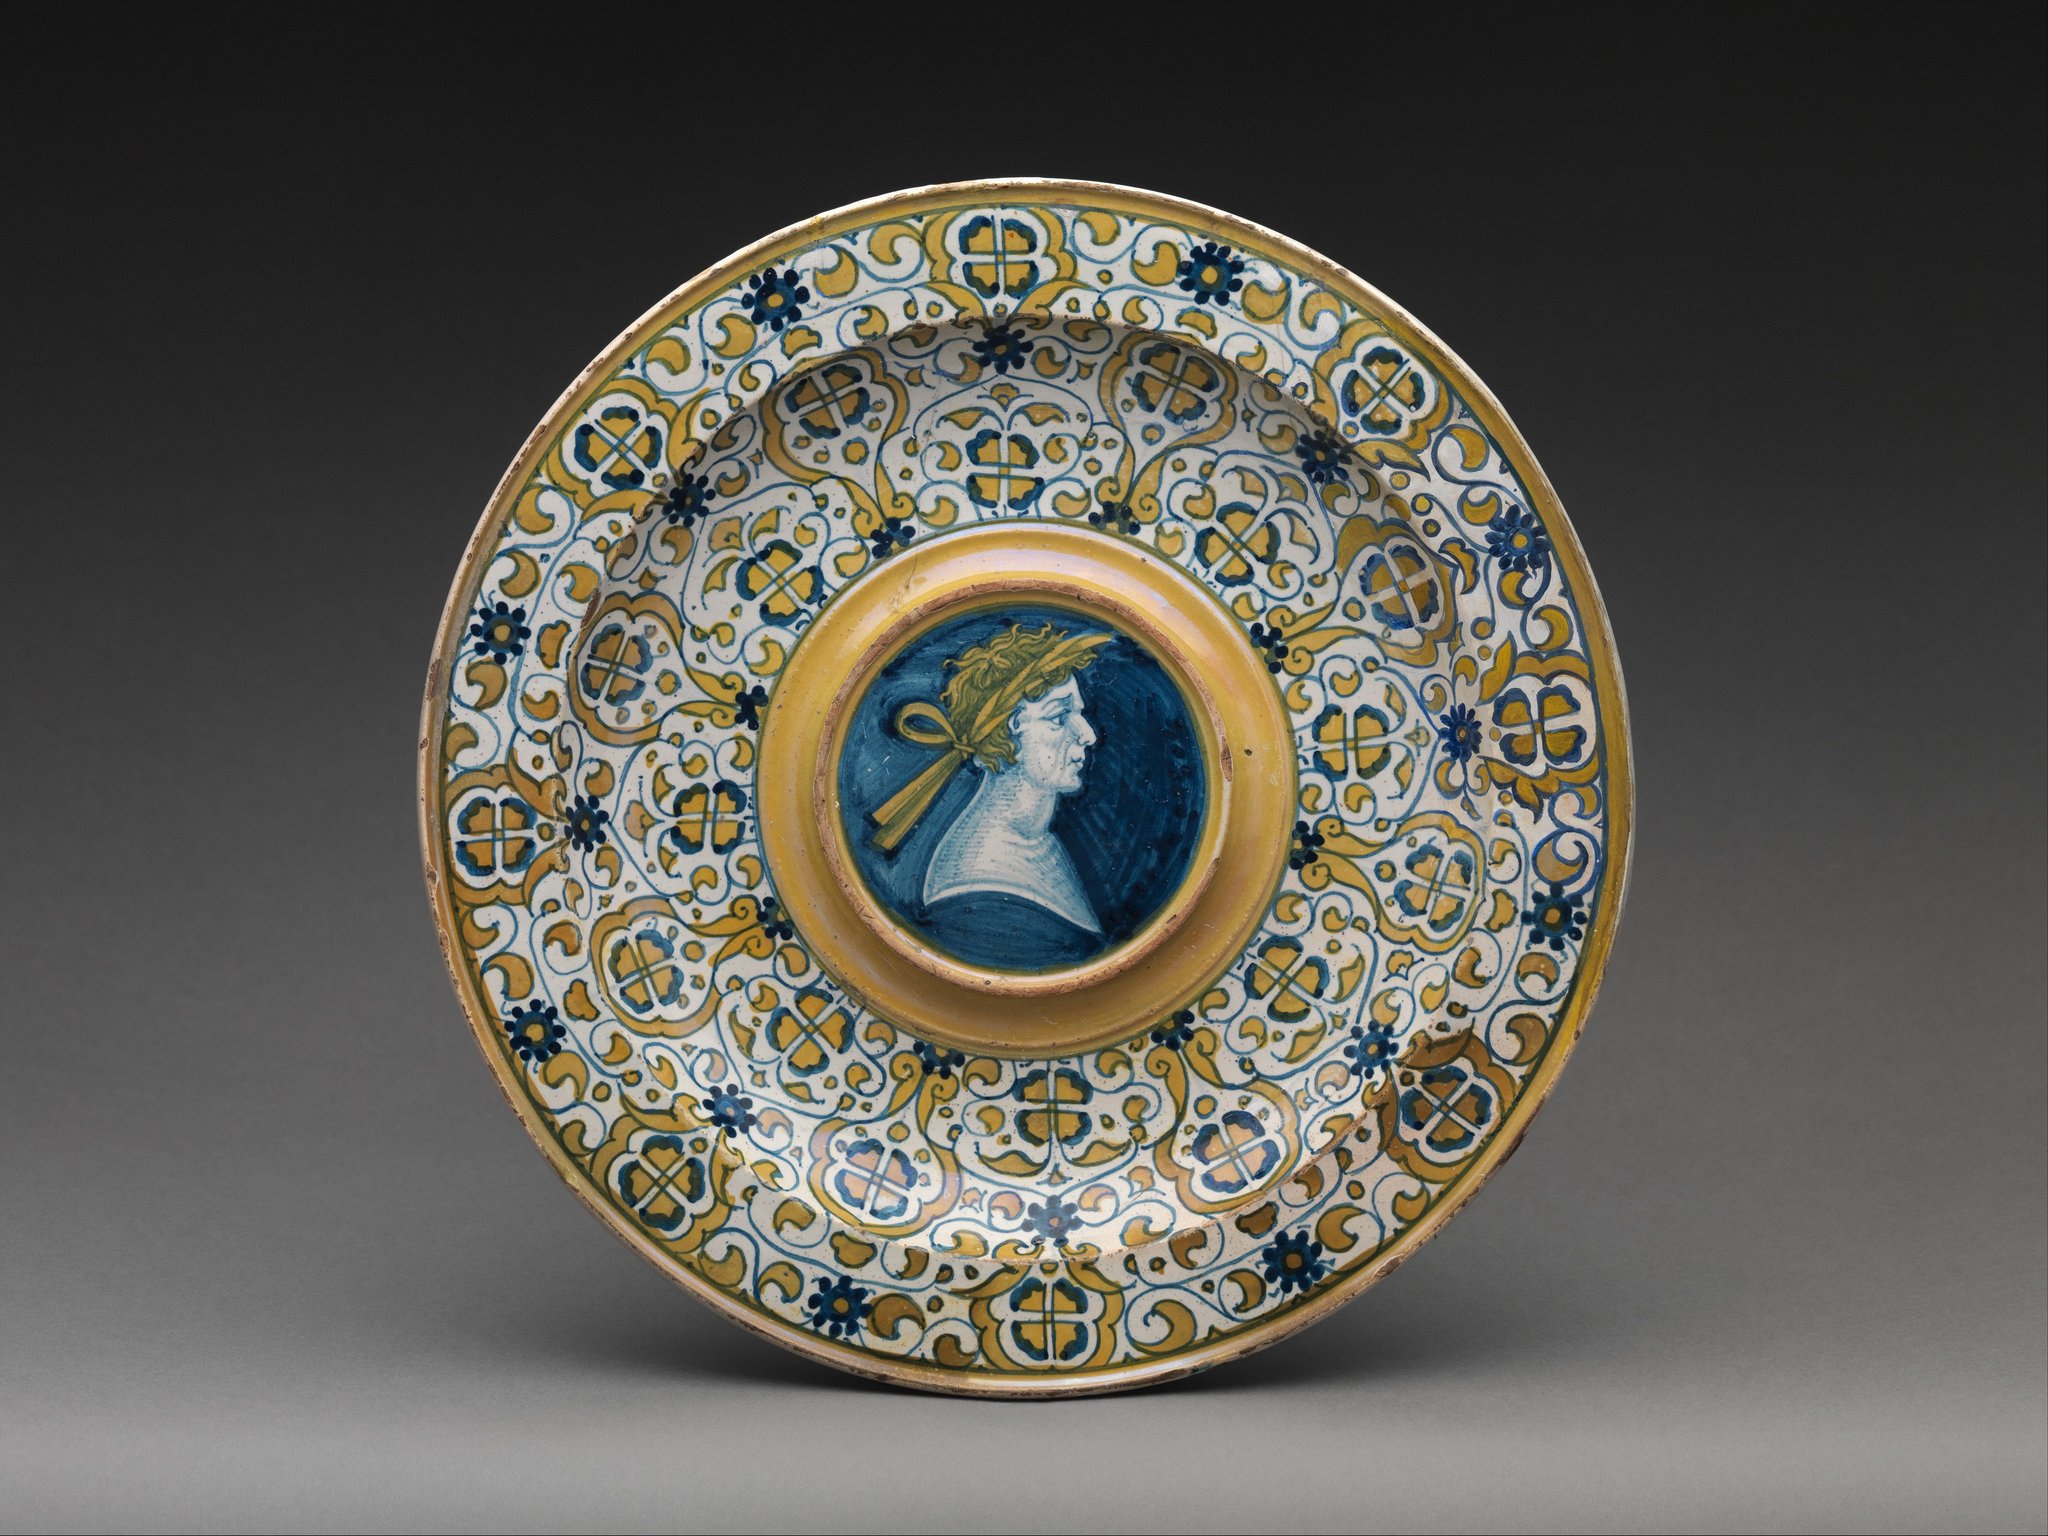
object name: ewer stand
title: Ewer stand with classicizing head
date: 1520-1550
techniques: maiolica, glazing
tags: heads,men,profiles